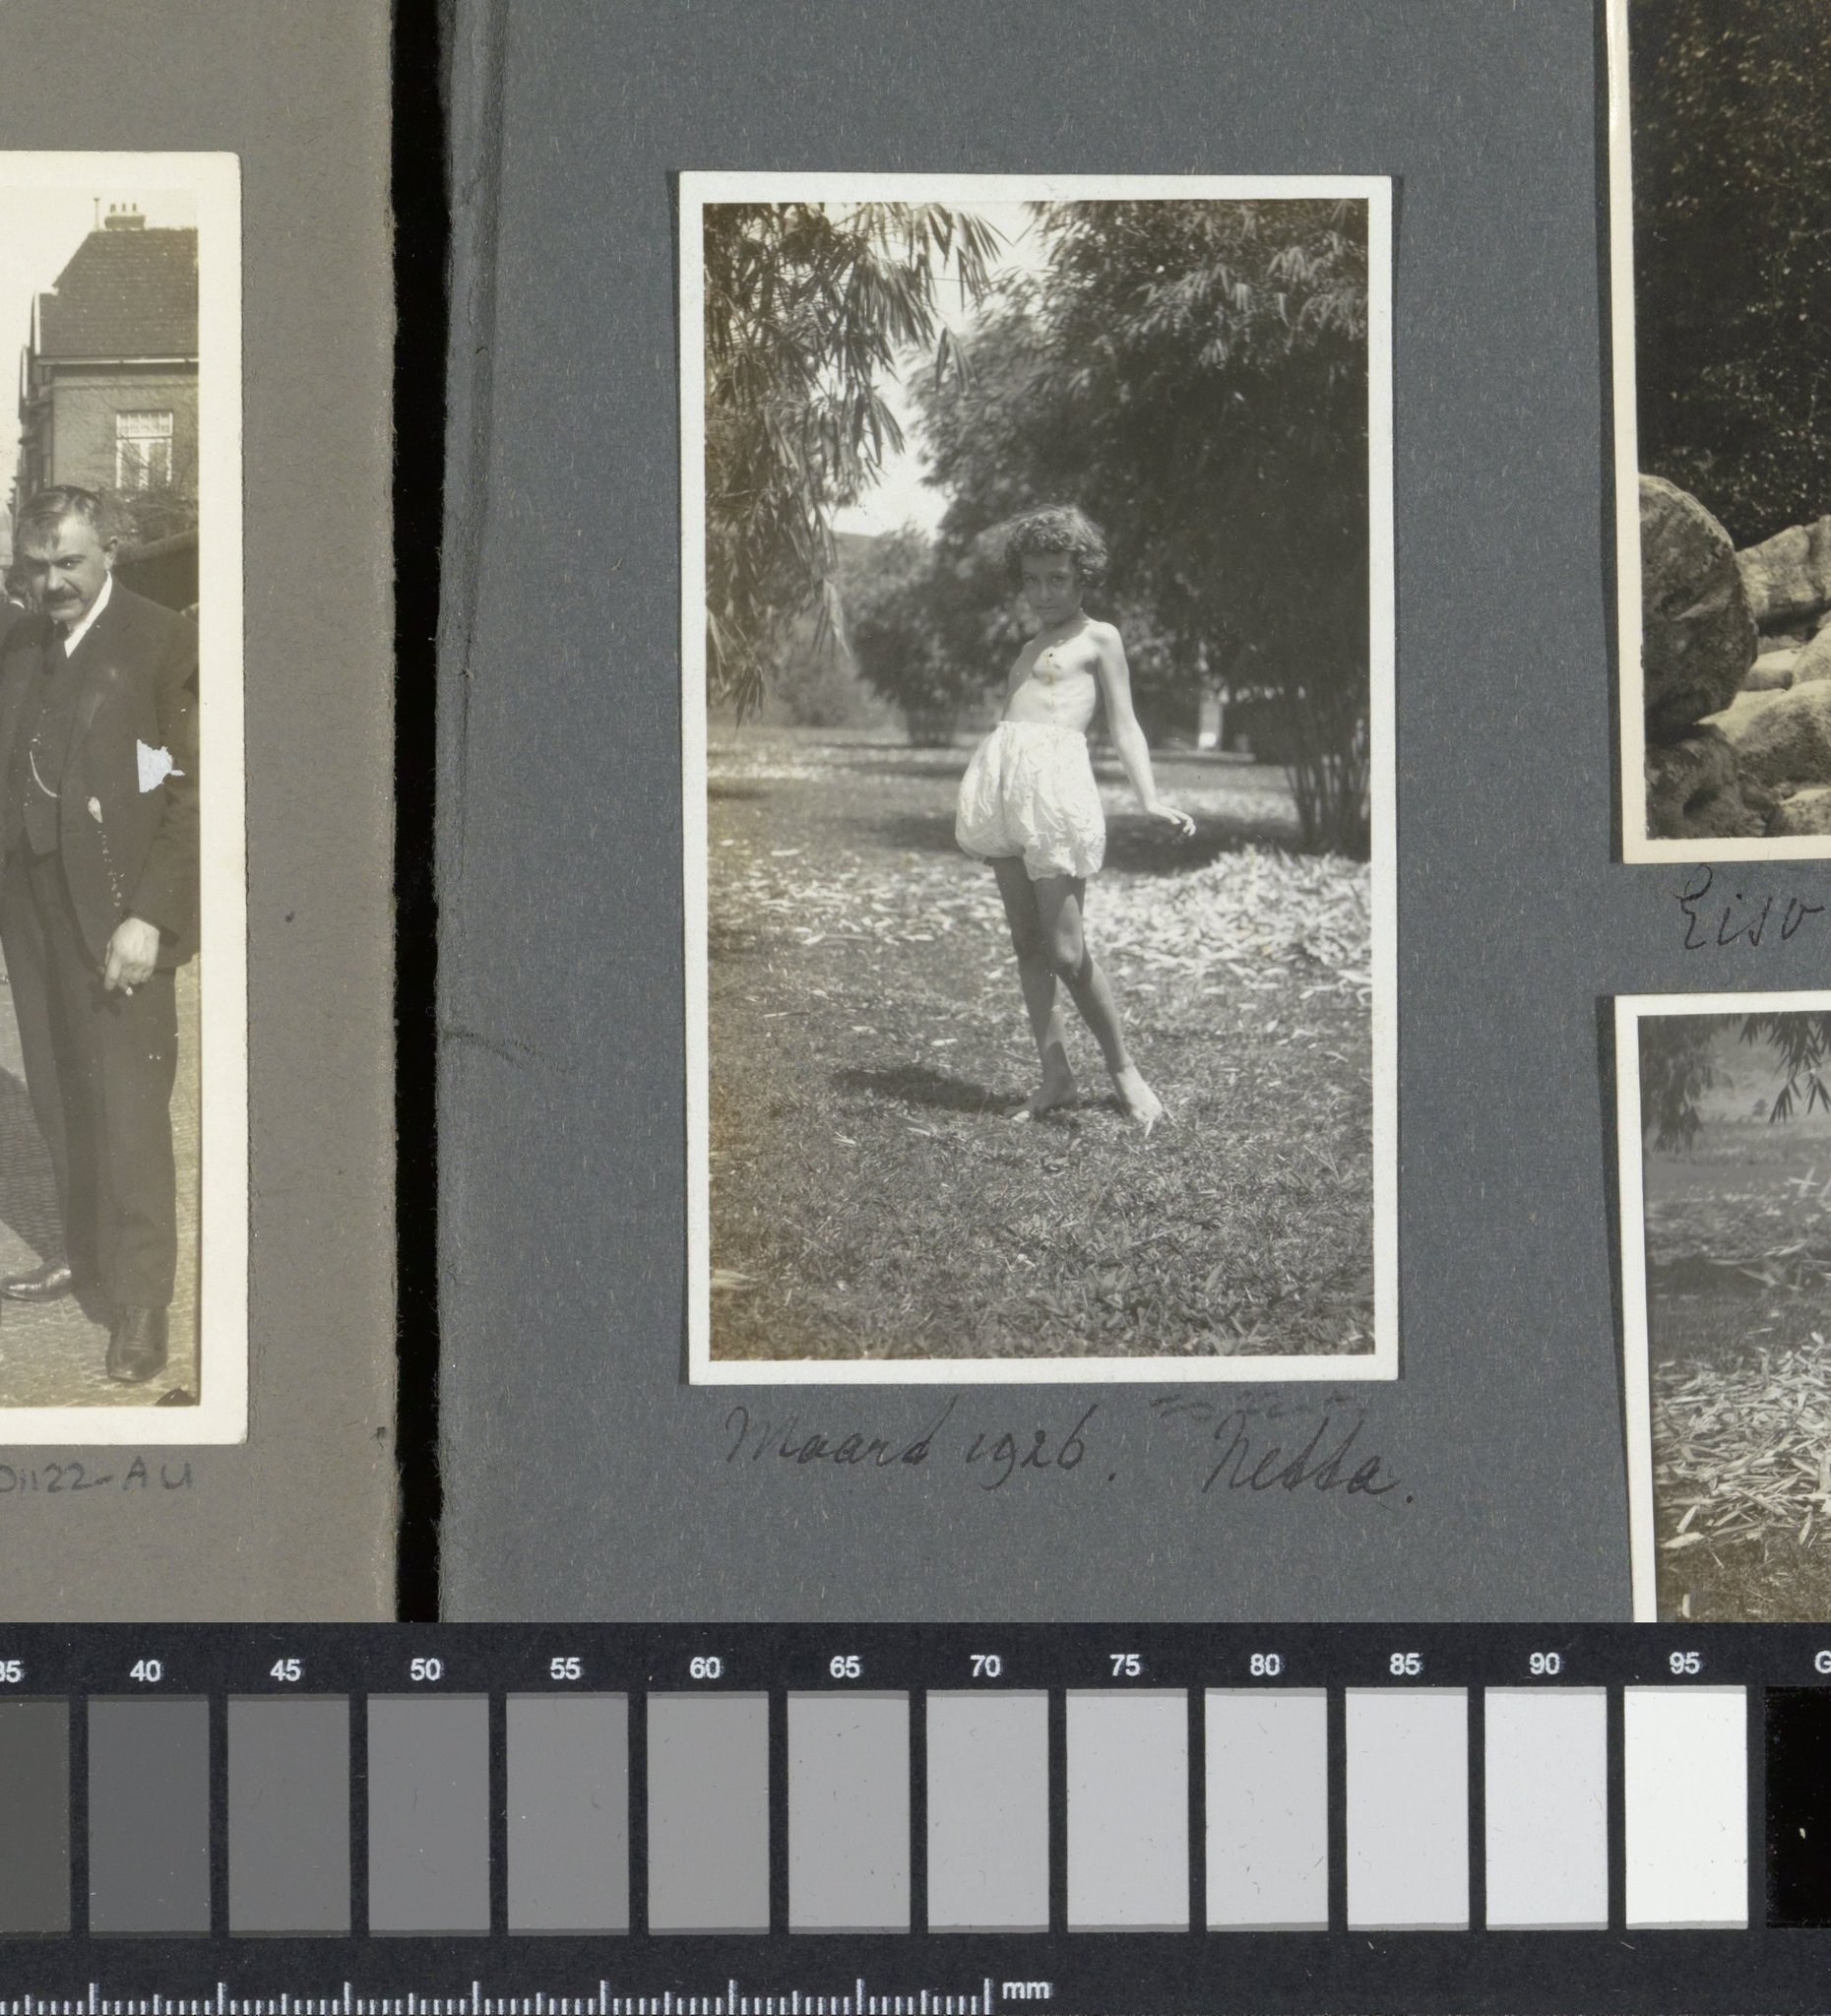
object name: photograph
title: Portret van Netta Bergsma als kind in pofbroek in een tuin op Sumatra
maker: Anonymous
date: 1903-1926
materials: photographic support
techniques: gelatin silver print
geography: sumatra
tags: trousers, breeches, child, sumatra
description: Onderdeel van fotoalbum met opnames van de familie Bergsma in Tandjong Poera en Rantan Pandjang (Sumatra).